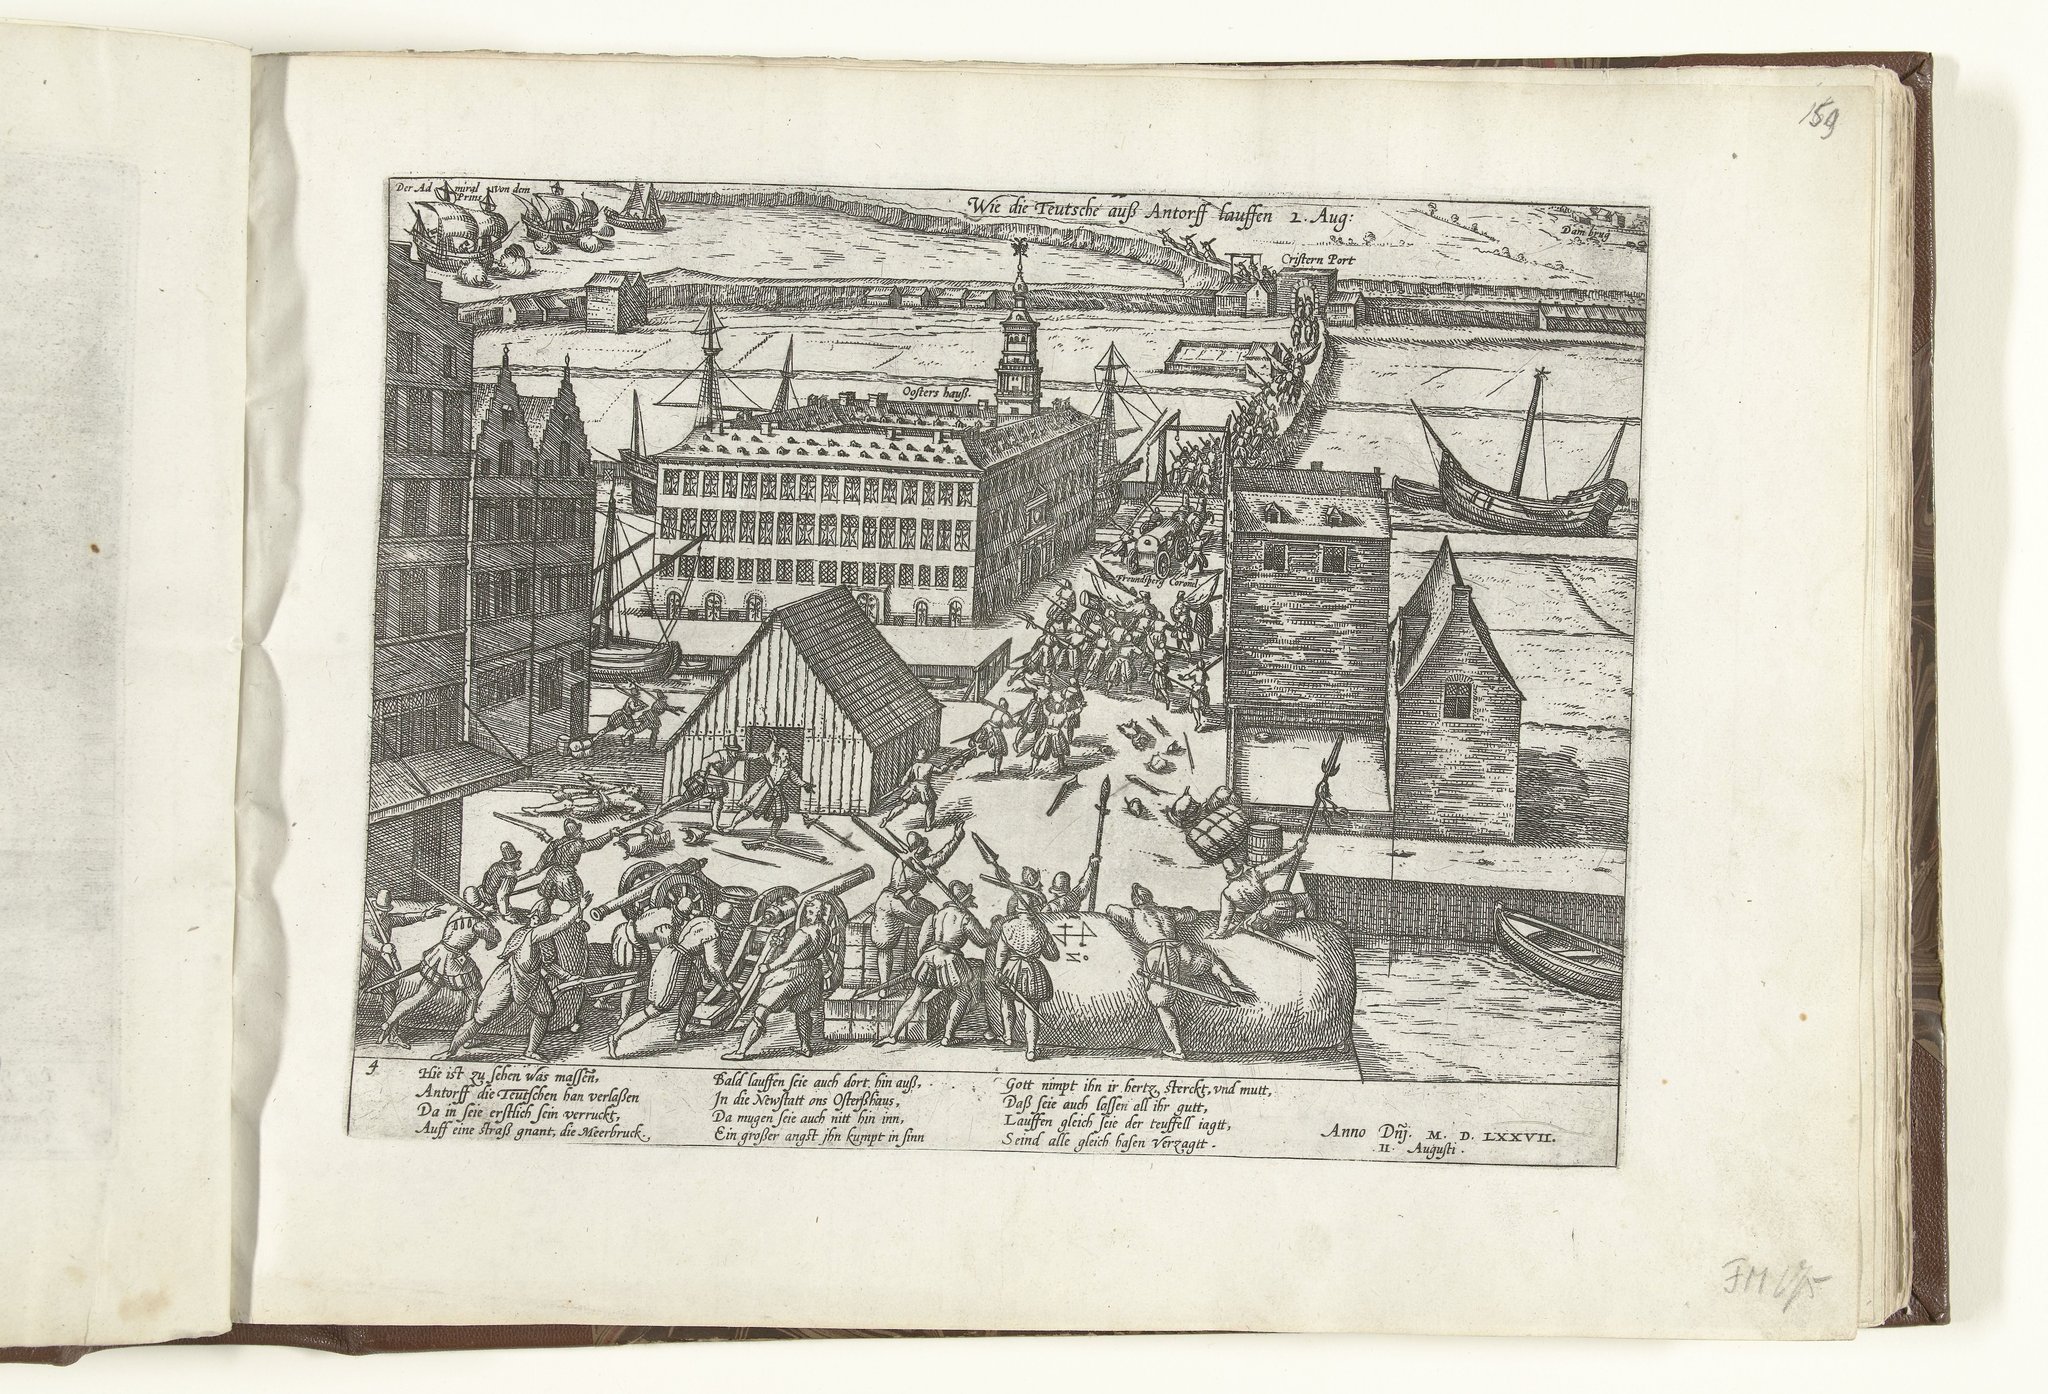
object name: album leaf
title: Serie 8: Nederlandse Gebeurtenissen, 1577-1583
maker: frans hogenberg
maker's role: print maker, publisher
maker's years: 1538-1590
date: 1577-1579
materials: paper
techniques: etching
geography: cologne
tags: citadel van antwerpen (16e eeuw), oostershuis, nieuwstad, strijd rond de citadel van antwerpen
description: De Duitse troepen trekken zich terug uit Antwerpen bij de Nieuwstad en het Oostershuis, 2 augustus 1577. Op de achtergrond rechts verlaten de Duitsers de stad, links aan de horizon de schepen van de vloot van de Prins. Met onderschrift van 12 regels in het Duits. Genummerd: 4.